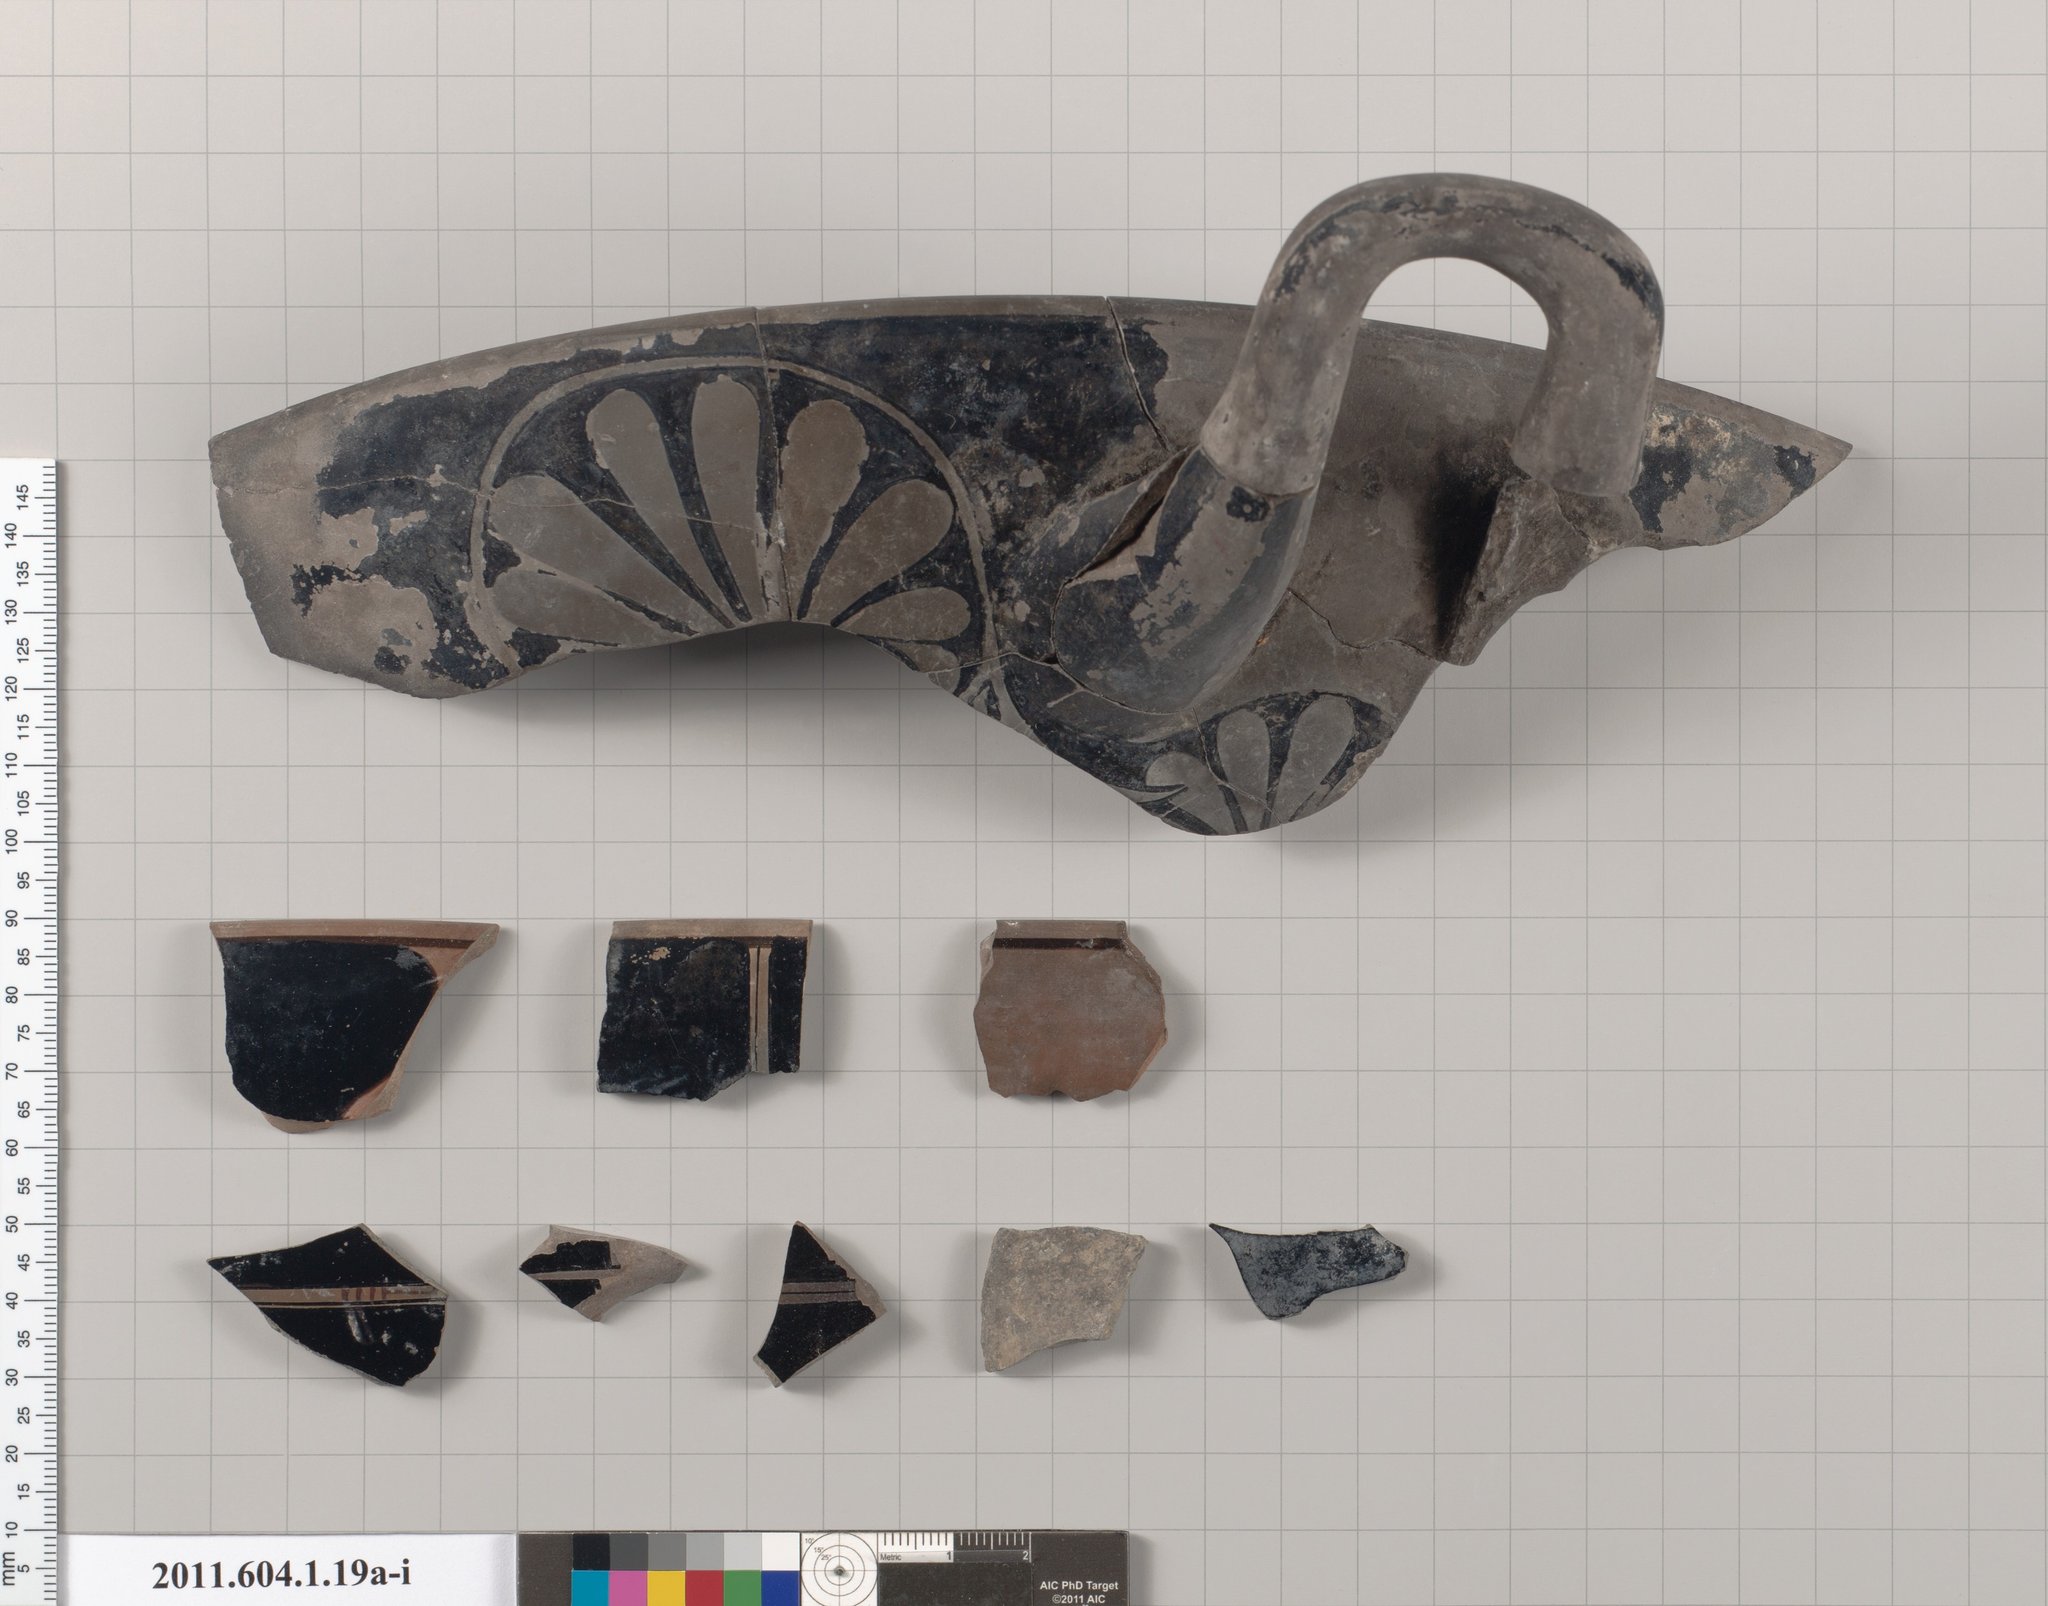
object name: kylix fragment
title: Terracotta fragments of a kylix (drinking cup)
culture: greek, attic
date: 534-501 BCE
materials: terracotta